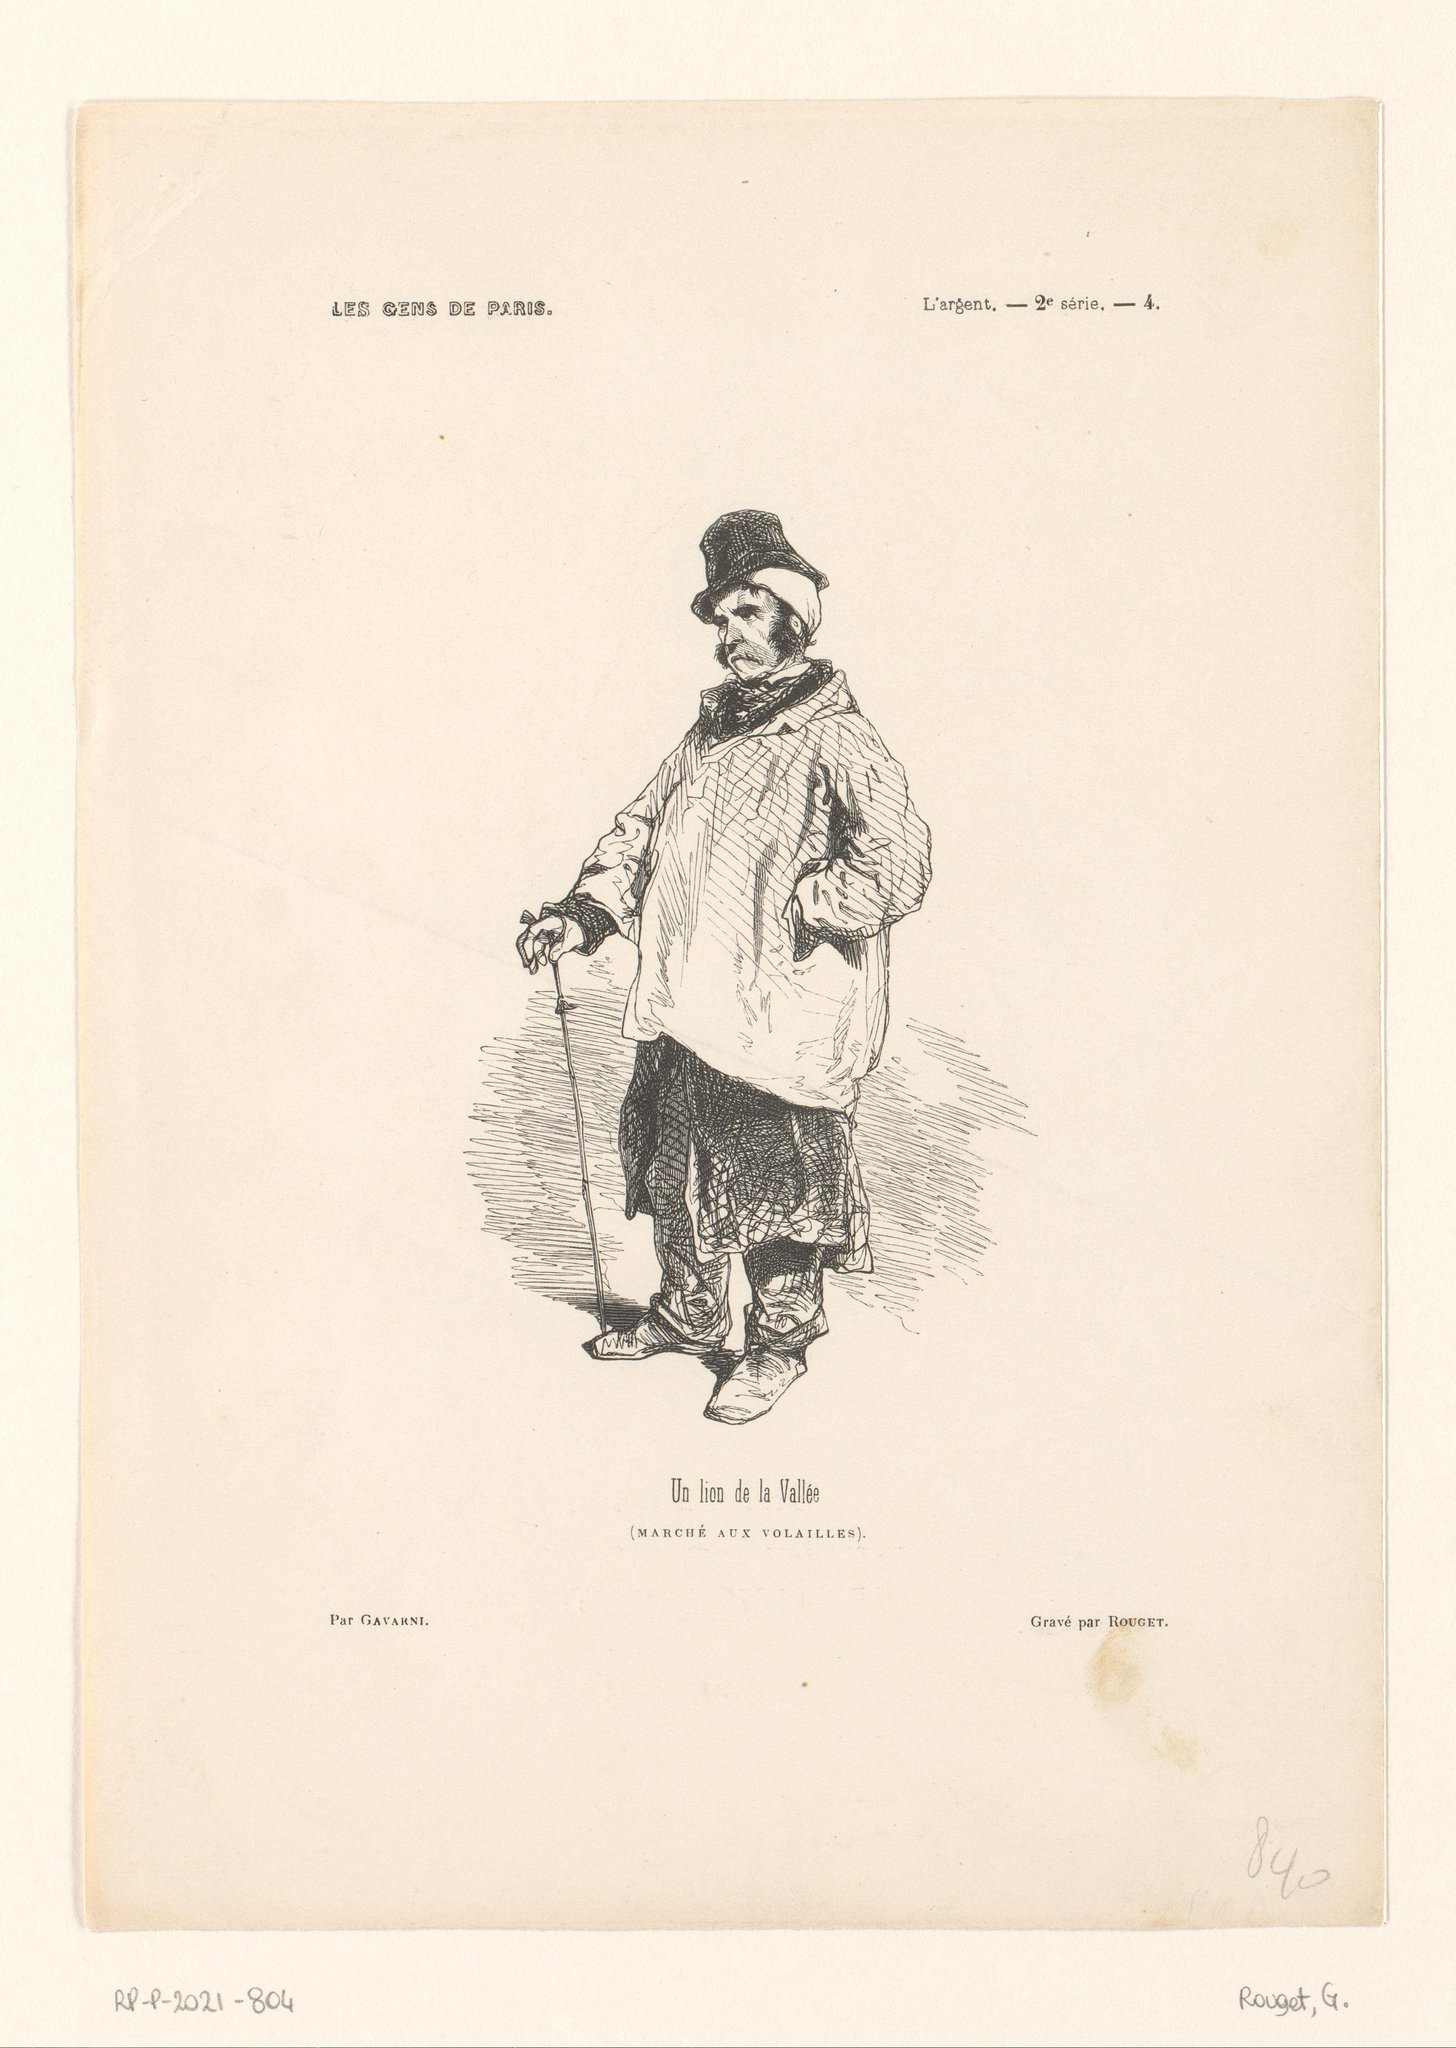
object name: book illustration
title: Un lion de la Vallée (marché aux Volailles)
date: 1846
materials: paper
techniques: letterpress printing, engraving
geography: france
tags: walking-stick, staff, head-gear: hat, paris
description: Prent waarschijnlijk uit: Sand, George. Le diable à Paris: Paris et les Parisiens (...). Parijs: J. Hetzel, 1846.